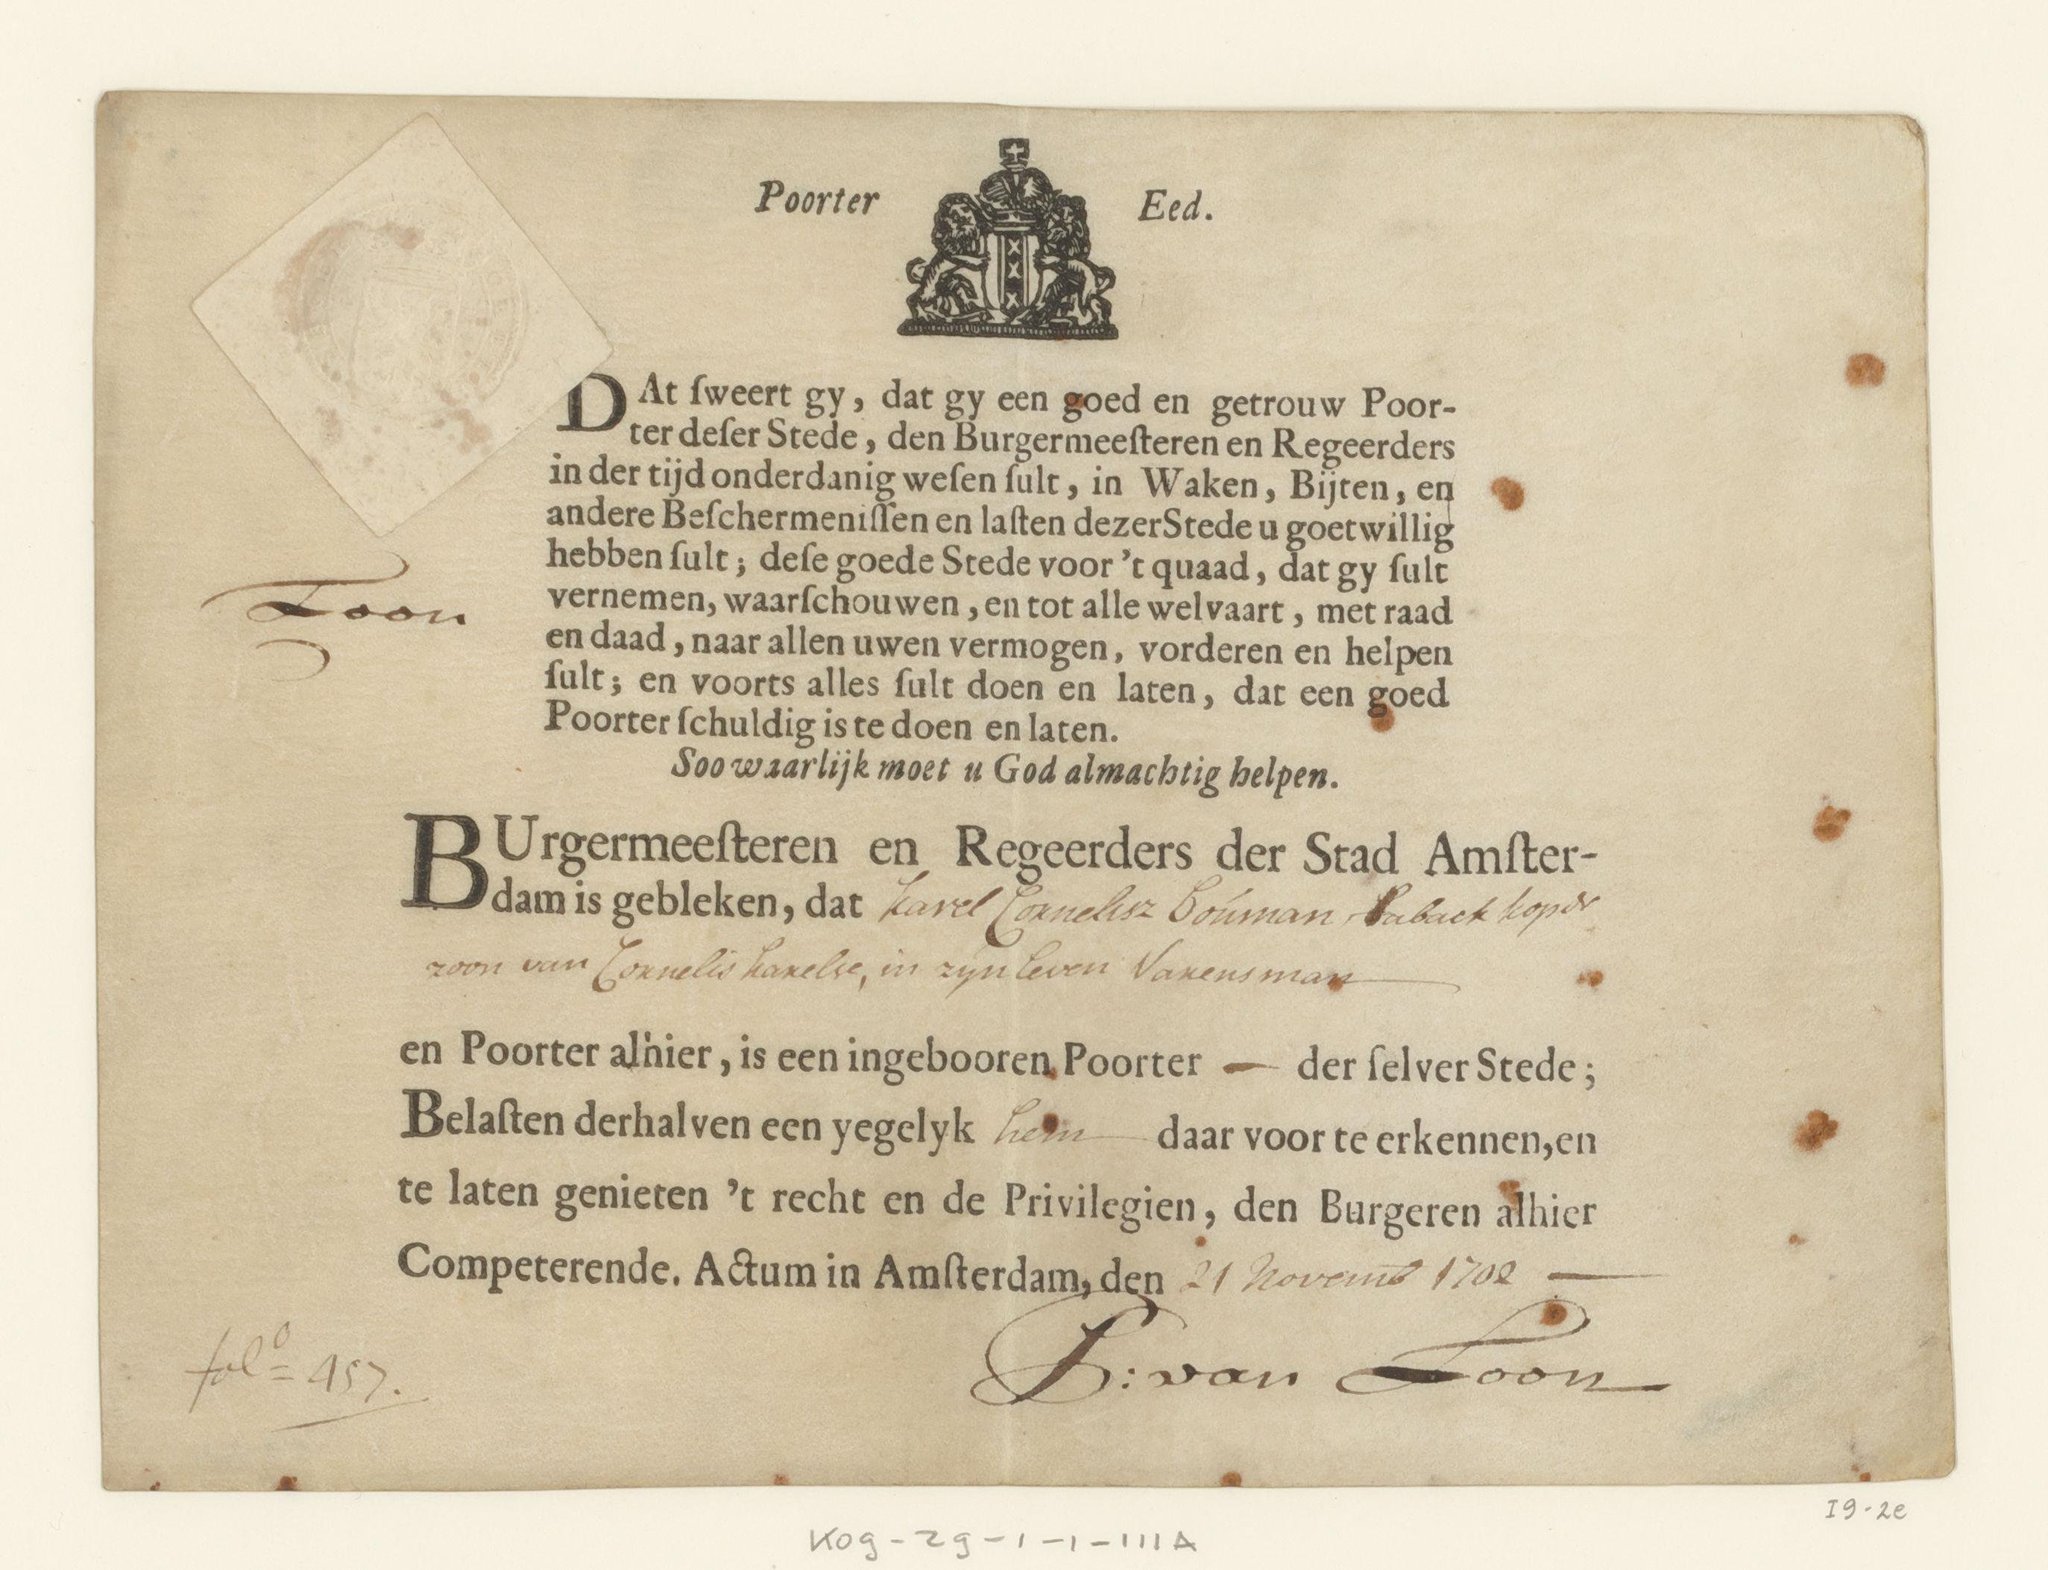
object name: document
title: Amsterdams poorterbriefje voor Karel Cornelisz Bouman, 1702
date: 1702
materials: parchment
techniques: letterpress printing, pen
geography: amsterdam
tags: amsterdam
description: Al in de dertiende eeuw werd er in Amsterdam onderscheid gemaakt tussen inwoners en poorters. Als iemand officieel poorter was had hij of zij méér rechten en privileges dan bewoners die geen poorter waren. (...) Amsterdammers die poorter wilden worden dienden zich te vervoegen op het stadhuis en de eed (of een belofte) af te leggen. Hierin belooft men plechtig een trouw en goed poorter van Amsterdam te zullen zijn. Als bewijs kreeg de kersverse poorter een kwitantie mee, het zogenoemde poorterbriefje, poorterakte of poortercedul. (Bron: Gemeente Amsterdam Stadsarchief).